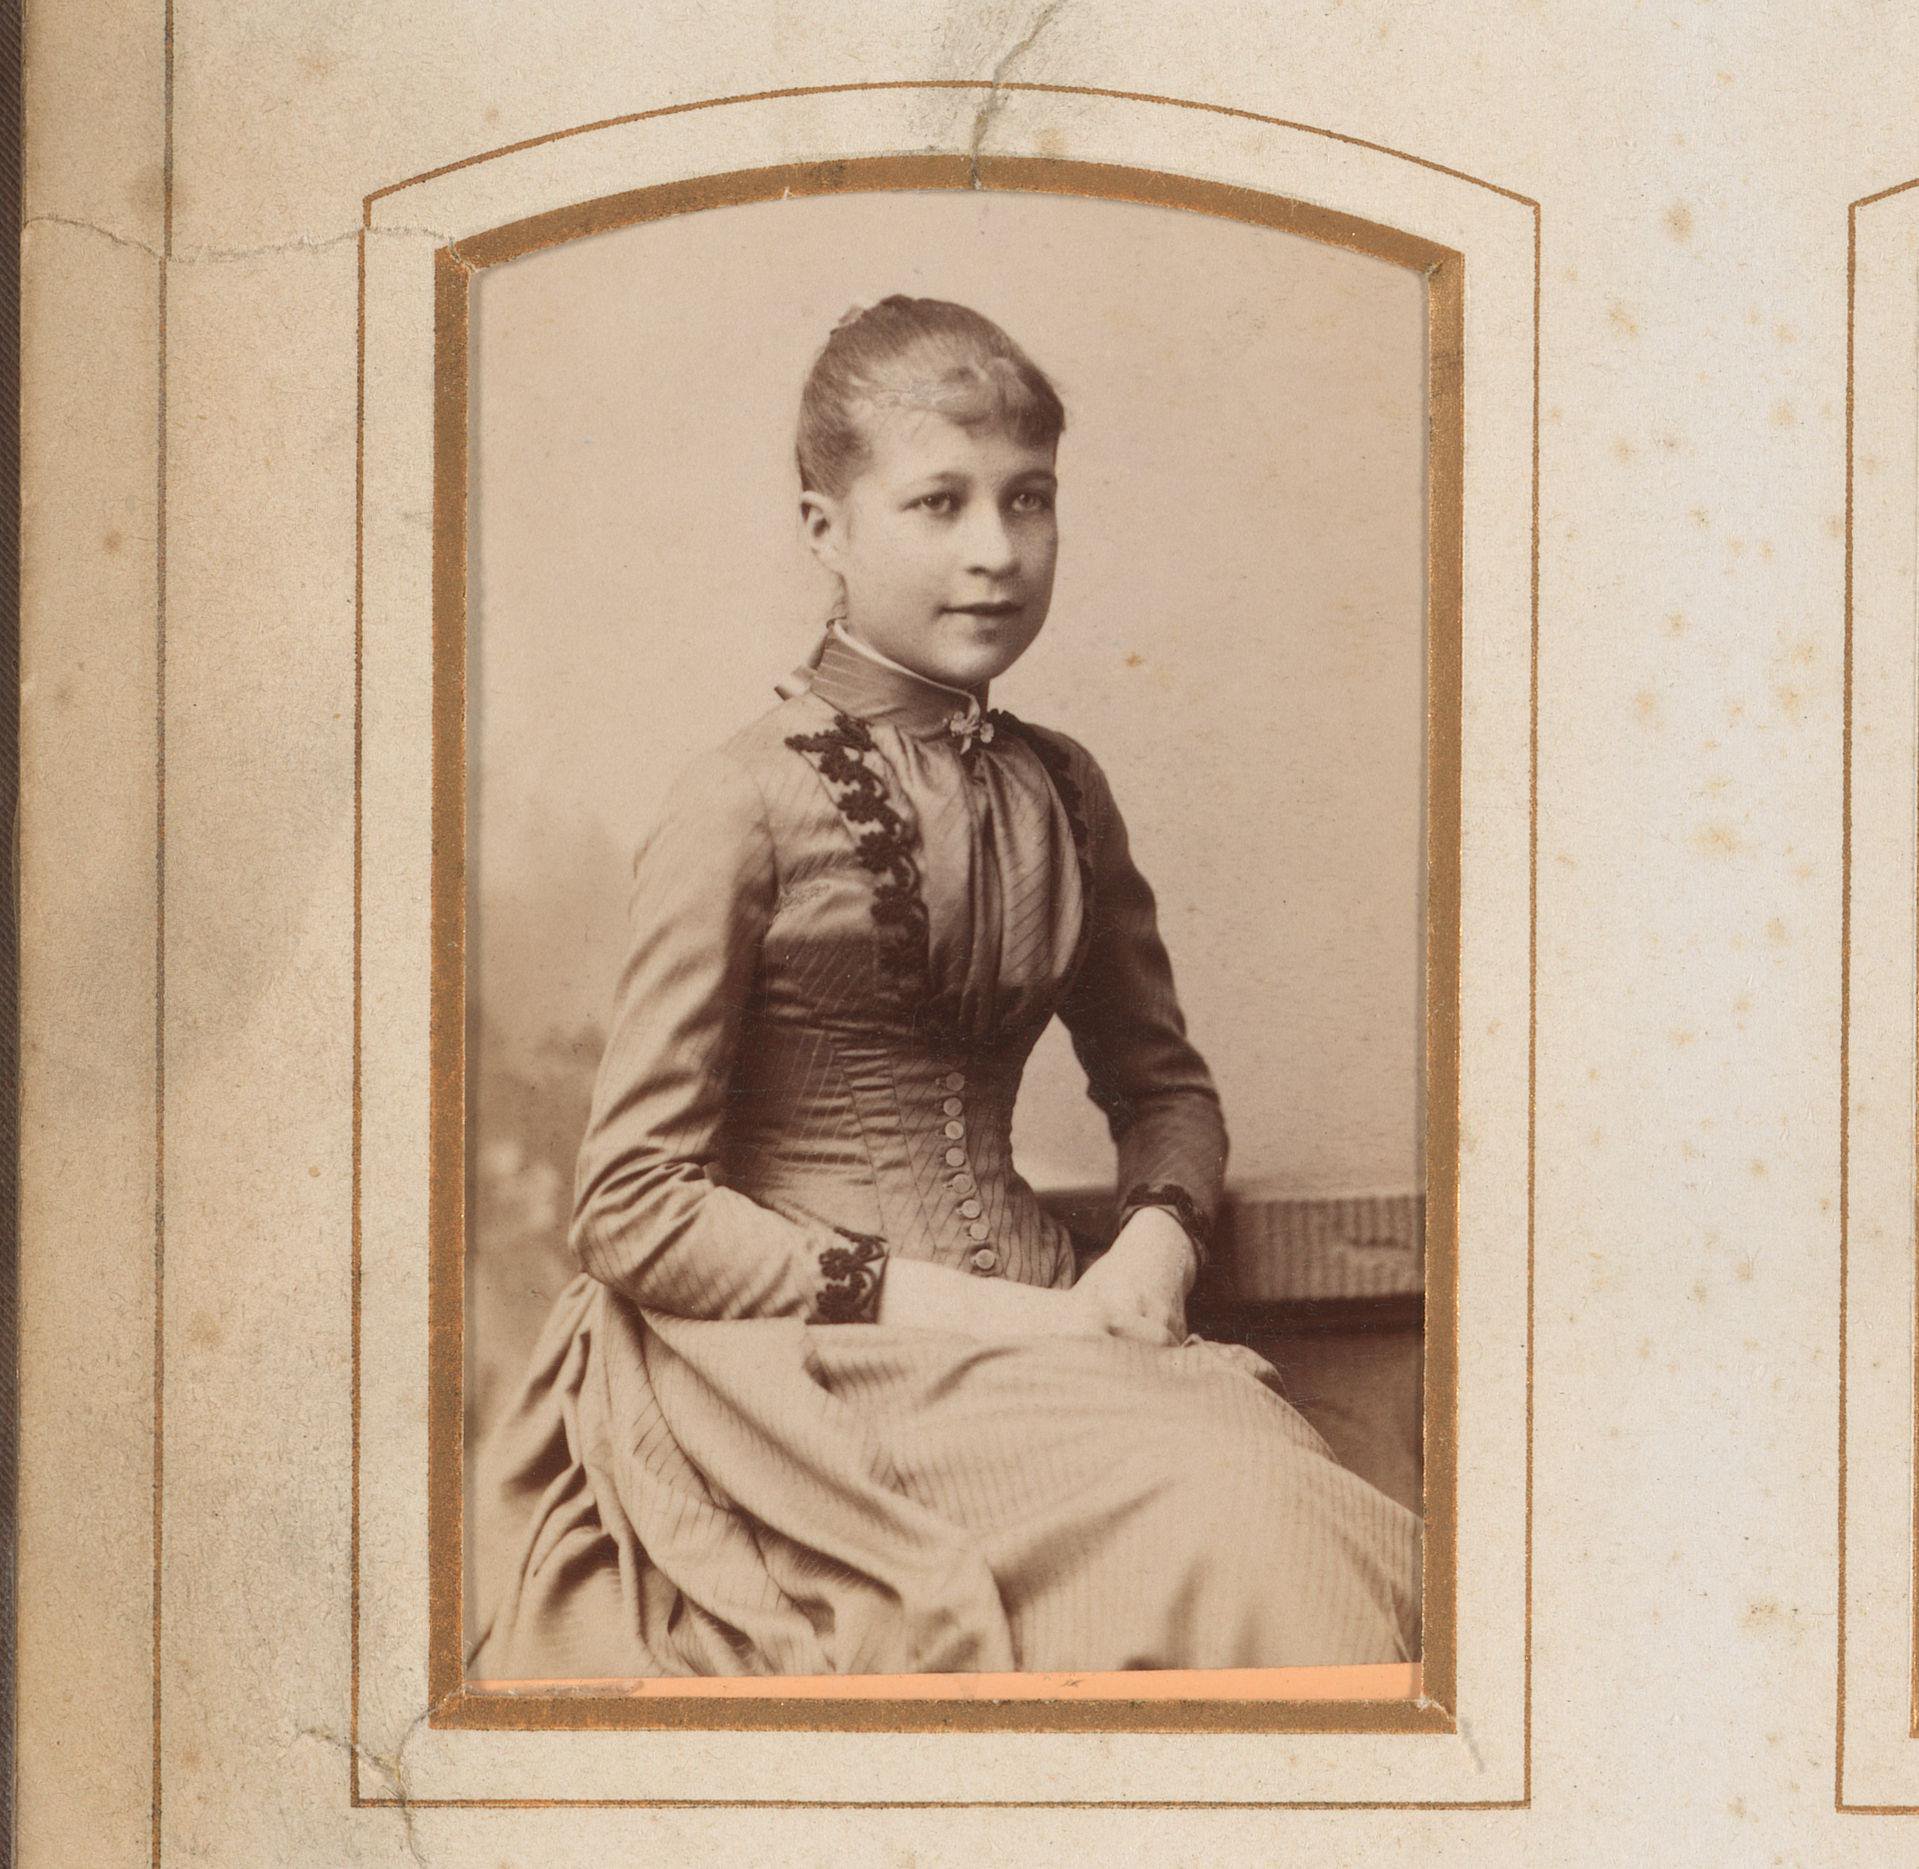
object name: photograph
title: Portret van een zittende jonge vrouw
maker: wilhelm jor eurenius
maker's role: fotograaf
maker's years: 1863-1925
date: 1860-1900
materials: cardboard, photographic support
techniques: albumen print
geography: stockholm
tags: adolescent, young woman, maiden, sitting figure - aa - female human figure, historical persons - bb - woman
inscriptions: inscription: ‘W. Eurenius,/ Kongl. Hoffotograf/ STOCKHOLM/ Hamngatan no. 18./ Allm:Telefon 68.80.’